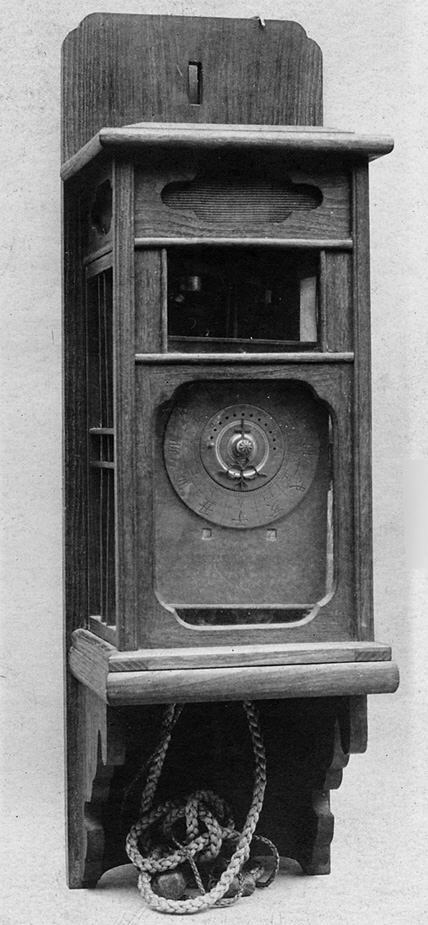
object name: clock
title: Bracket Clock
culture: japanese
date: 1801-1900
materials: brass, wood